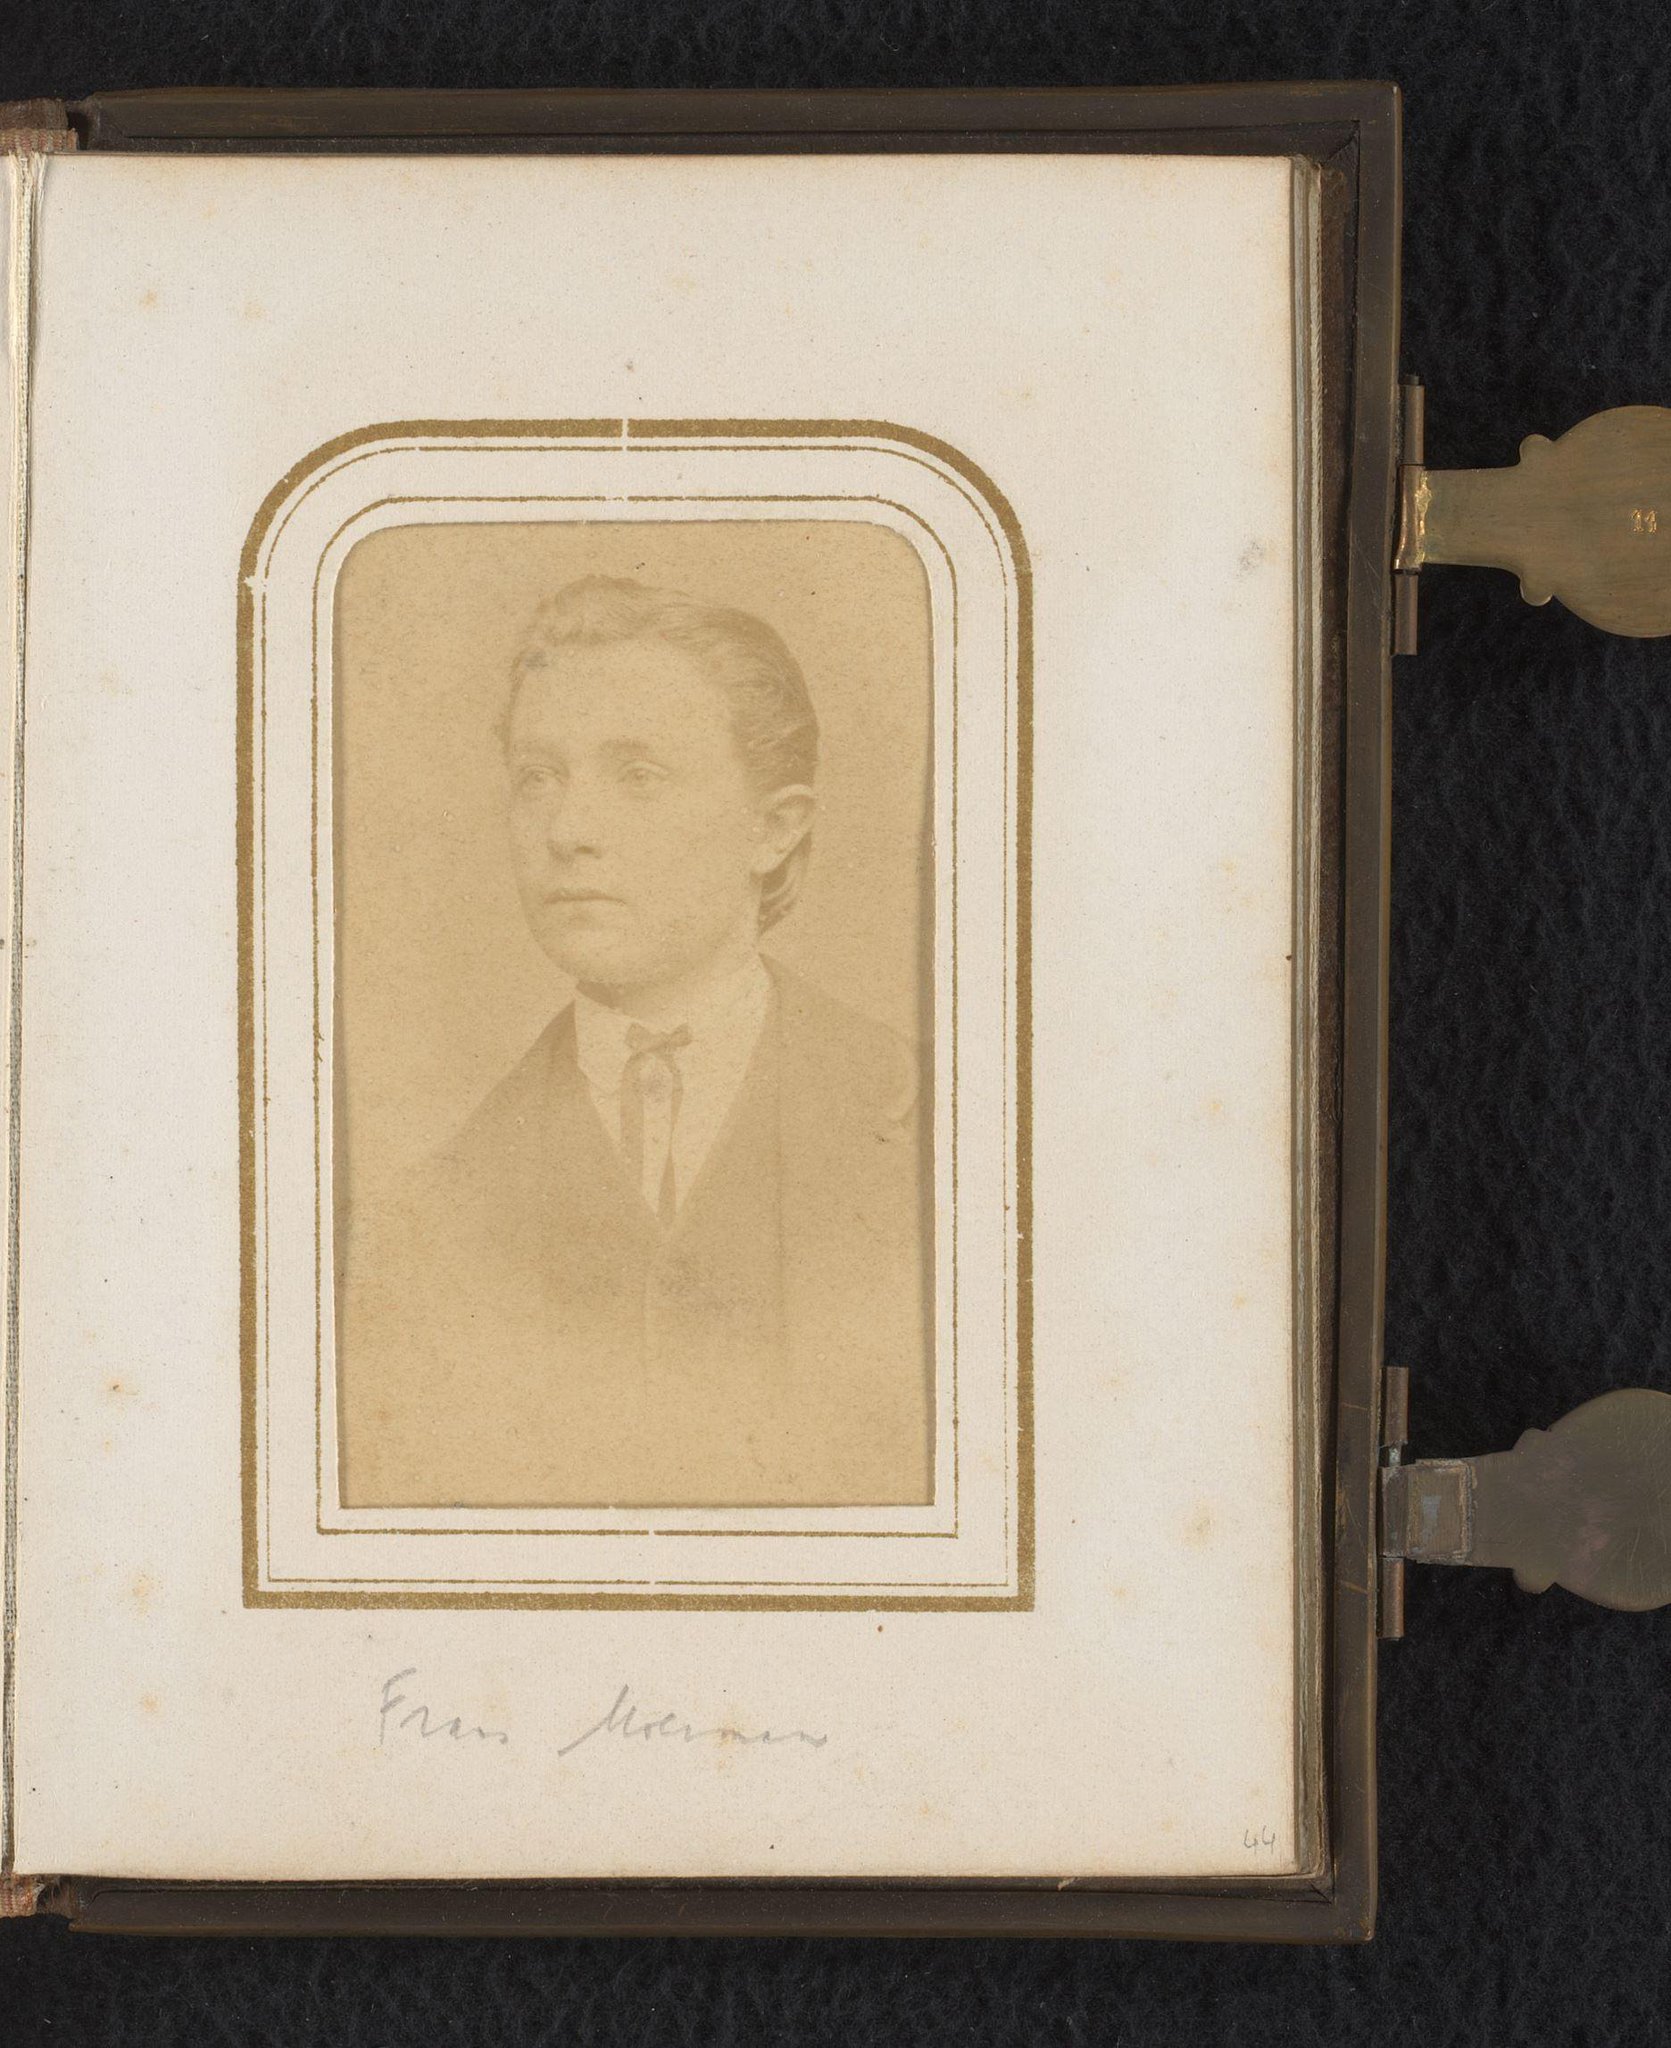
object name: album leaf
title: Portret van een man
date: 1868-1869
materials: cardboard, photographic support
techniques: albumen print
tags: adult man, historical persons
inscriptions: annotation: ‘Frans [...]’, inscription: ‘C. Janssens & E. Rademacher/ PHotographers/ Hofplein 14. 341/ Rotterdam’, annotation: ‘Frans [...]’